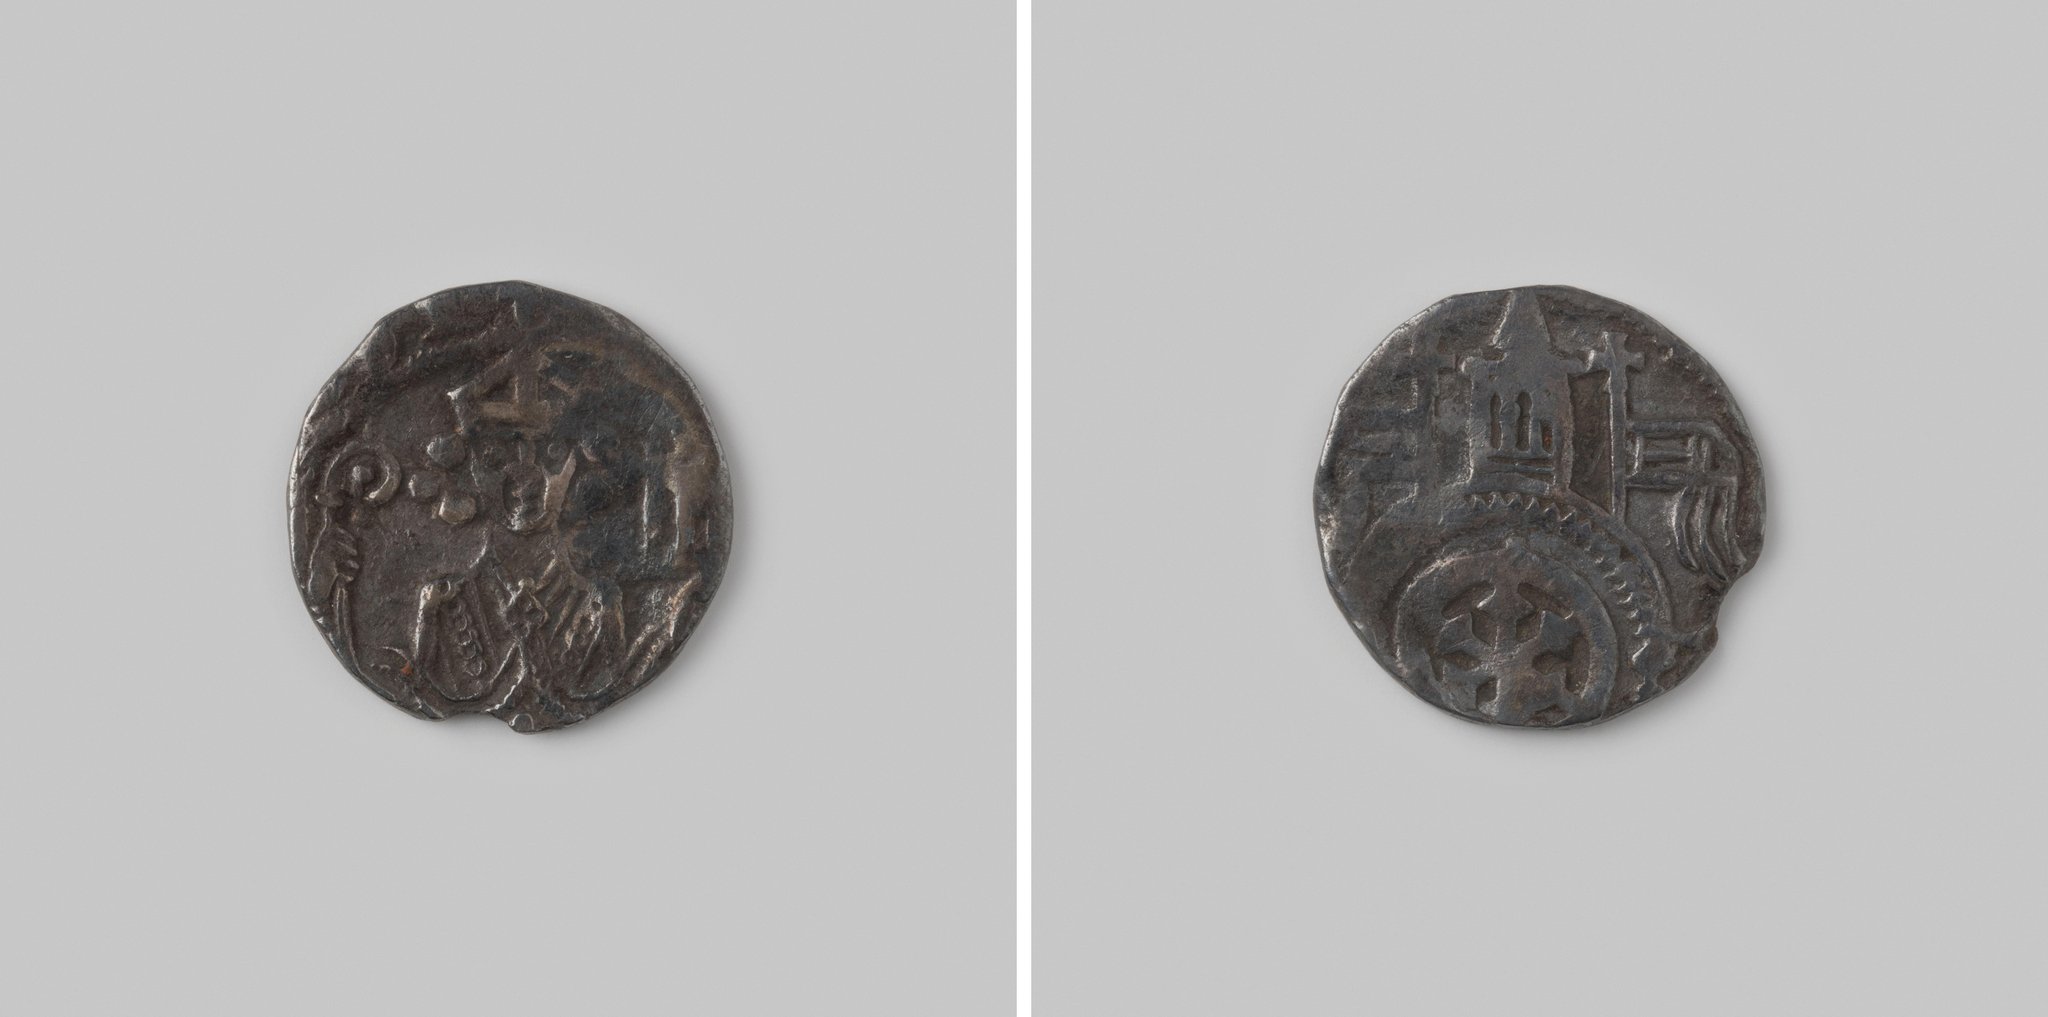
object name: coin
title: Bisdom Osnabrück, penning, Konrad II von Rietberg, 1270-1297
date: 1270-1297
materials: silver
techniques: striking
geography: osnabrück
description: Zilveren munt. Voorzijde: portret van bisschop van voren met in rechterhand staf. Keerzijde: kerkgebouw met poort, waarin rad, wapen van Osnabrück.